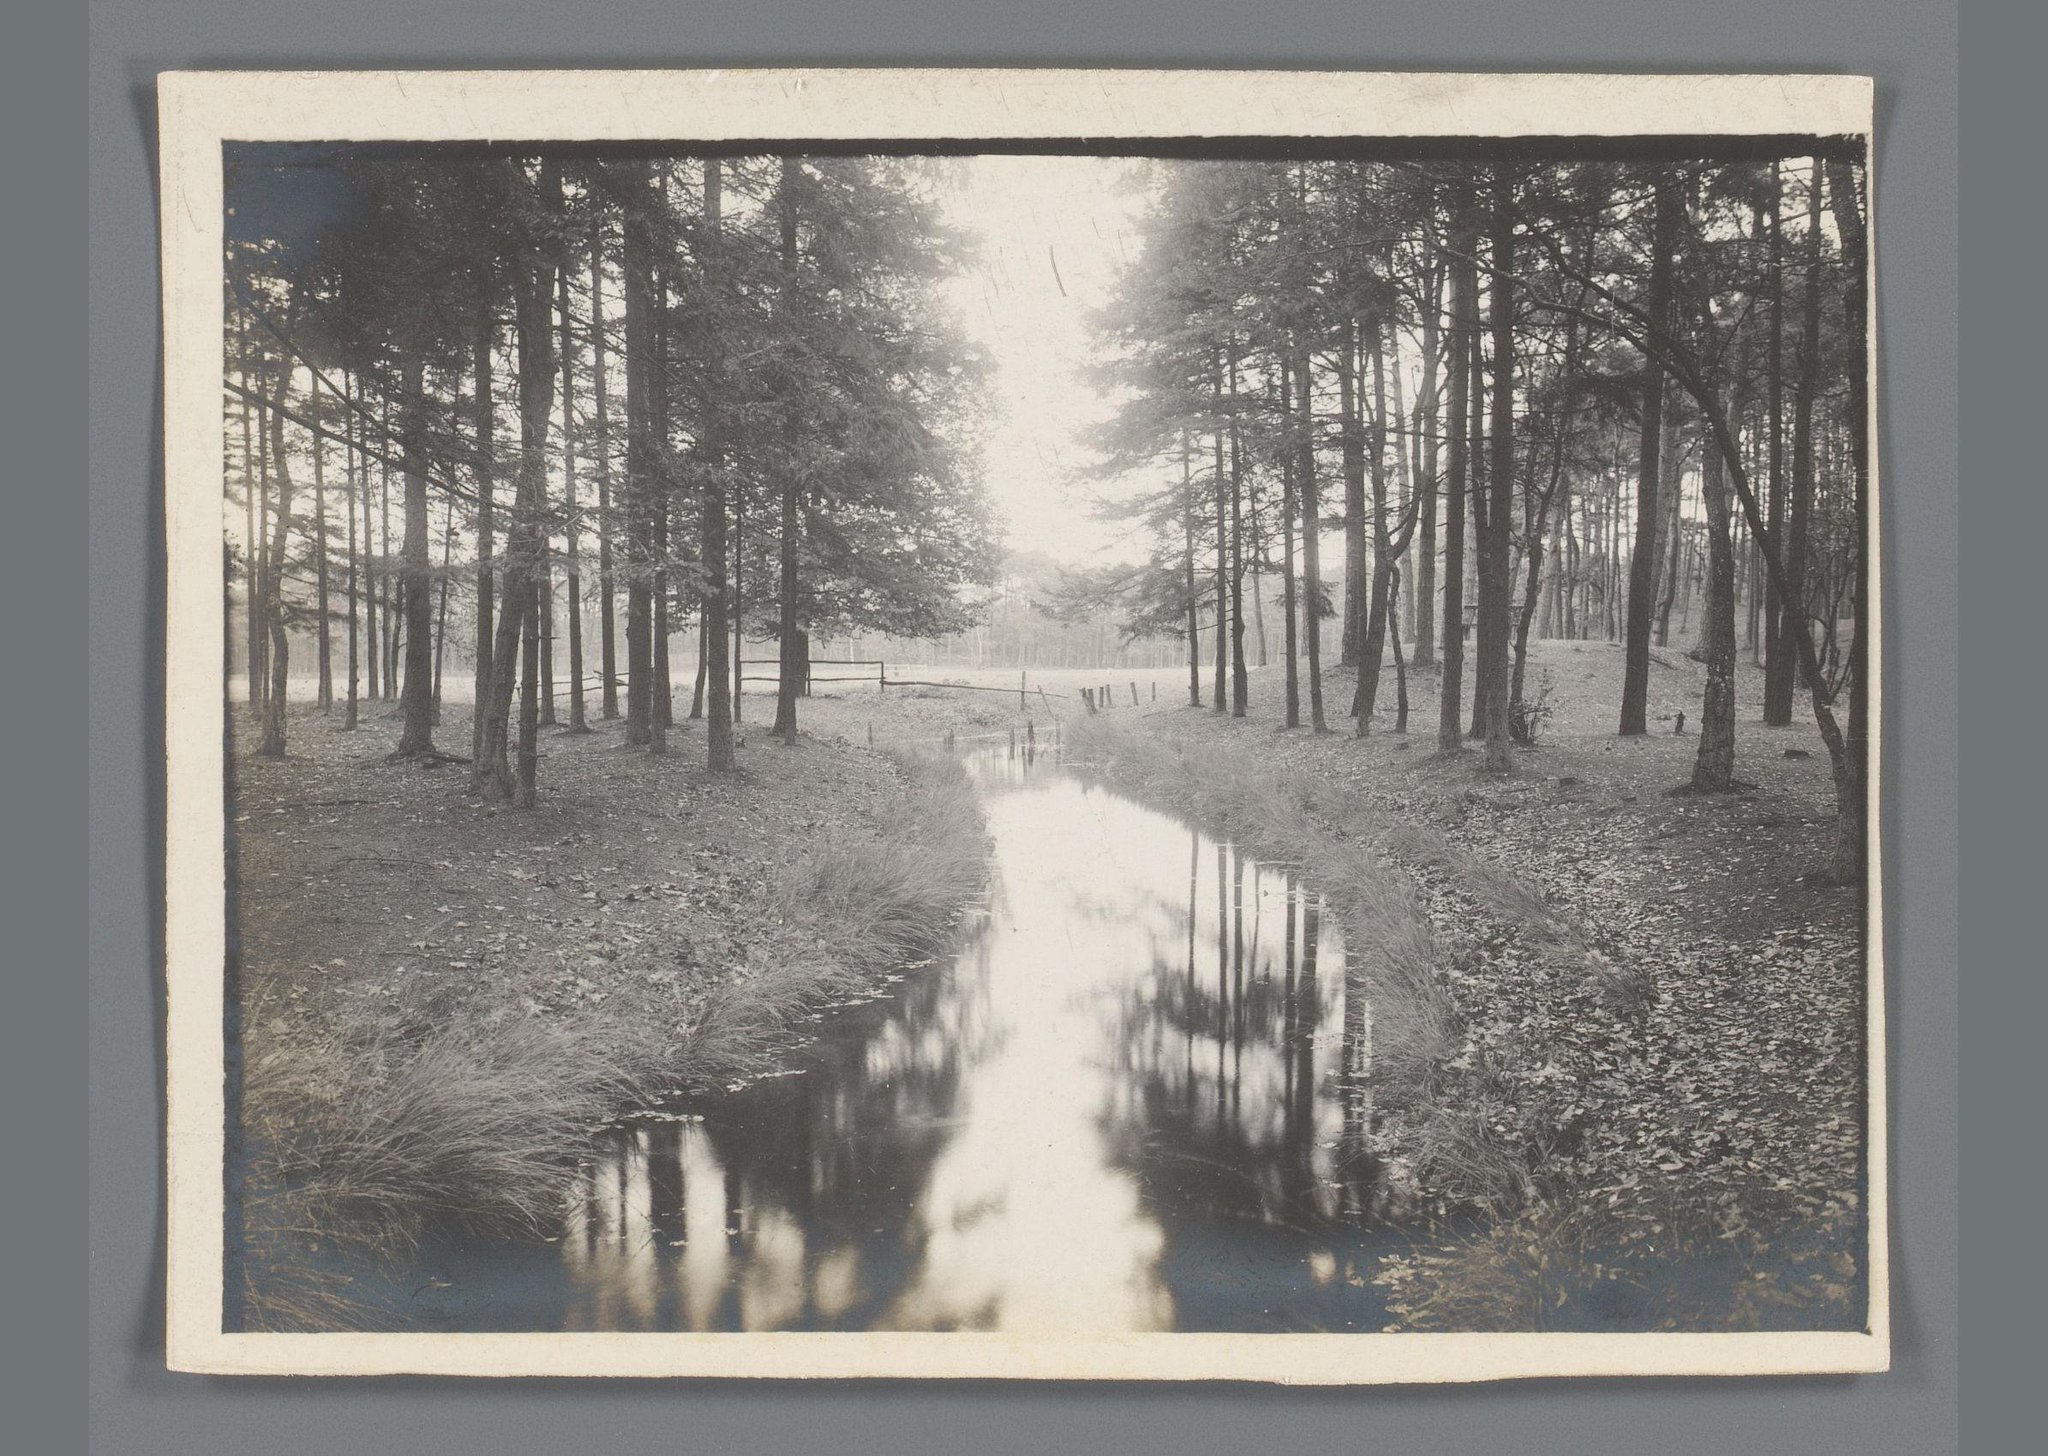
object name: photograph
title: Boslandschap met beek in Limburg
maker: willem de jong (fotograaf)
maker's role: arts, fotograaf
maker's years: 1864-1918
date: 1895-1918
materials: paper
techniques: gelatin silver print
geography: limburg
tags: forest, wood, spring, source of river or stream